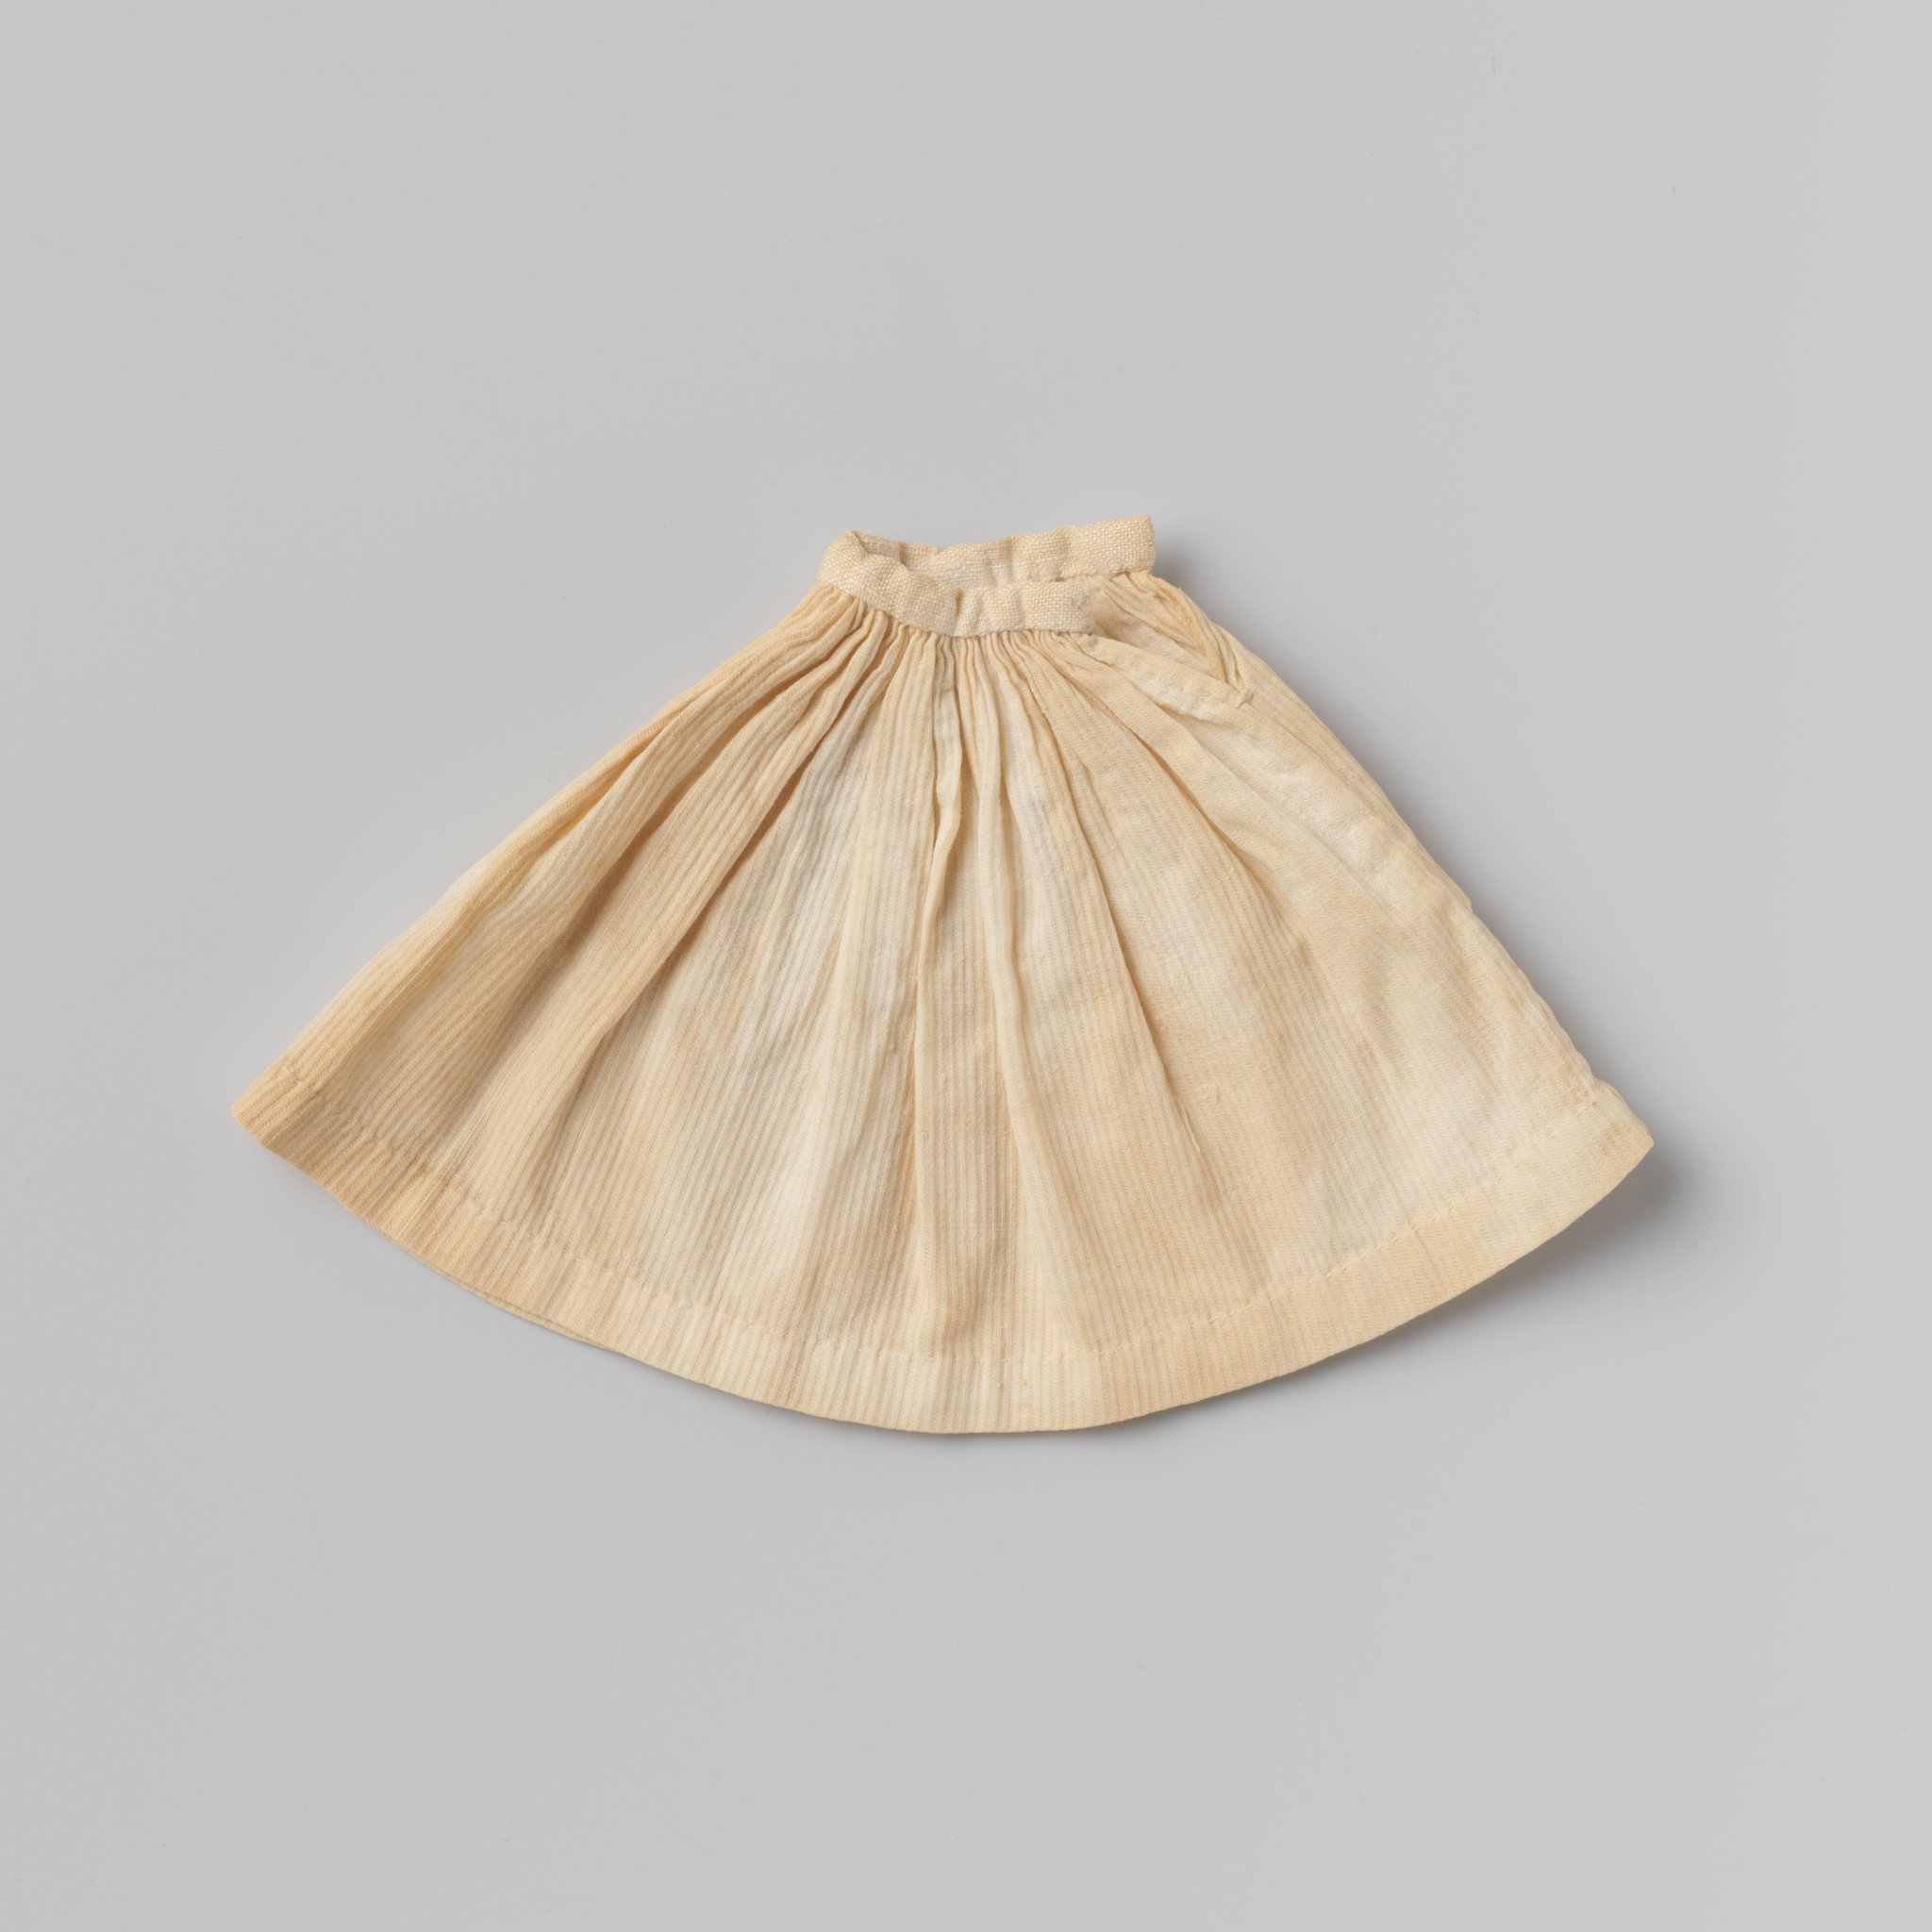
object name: doll's clothing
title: Onderrok met streepmotief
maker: Anonymous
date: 1750-1800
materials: cotton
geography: netherlands